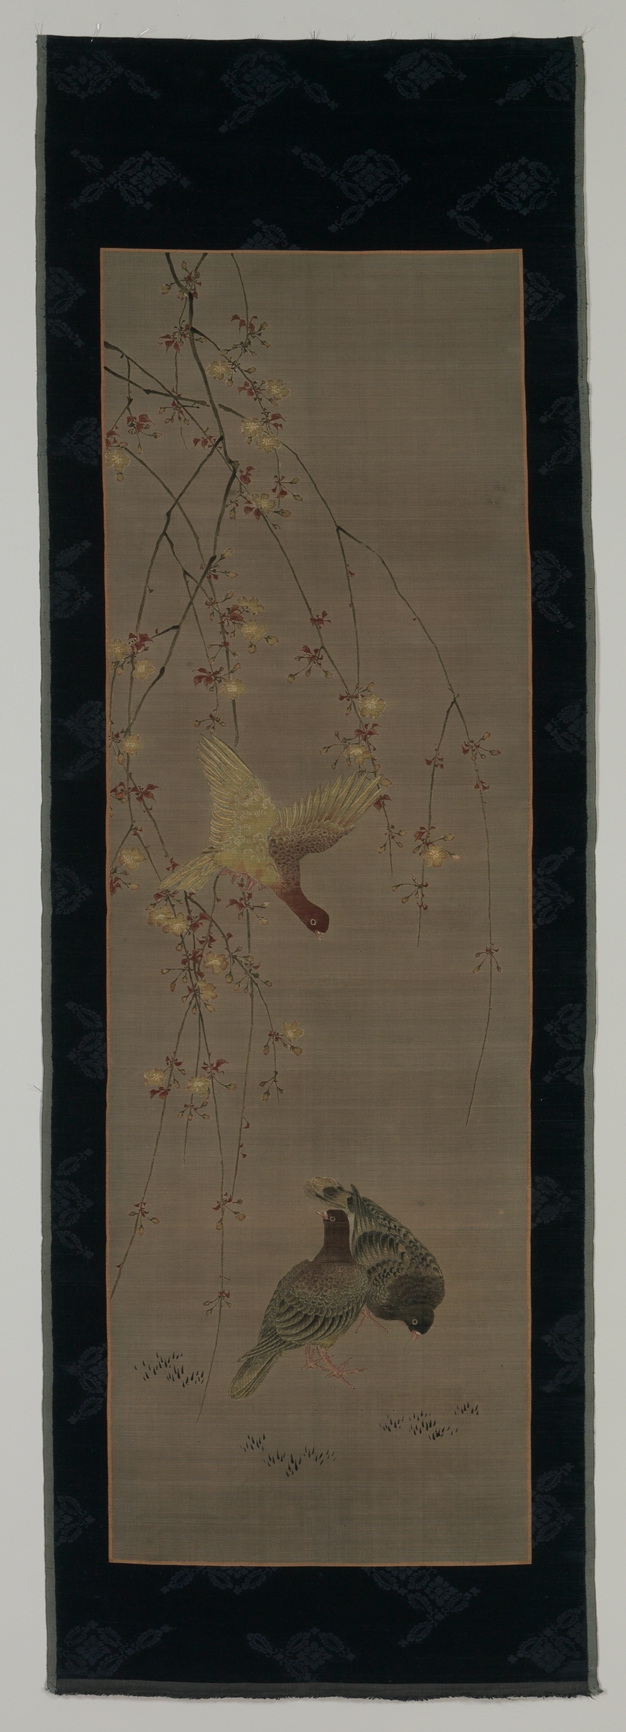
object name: panel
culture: japanese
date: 1767-1833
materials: silk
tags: birds